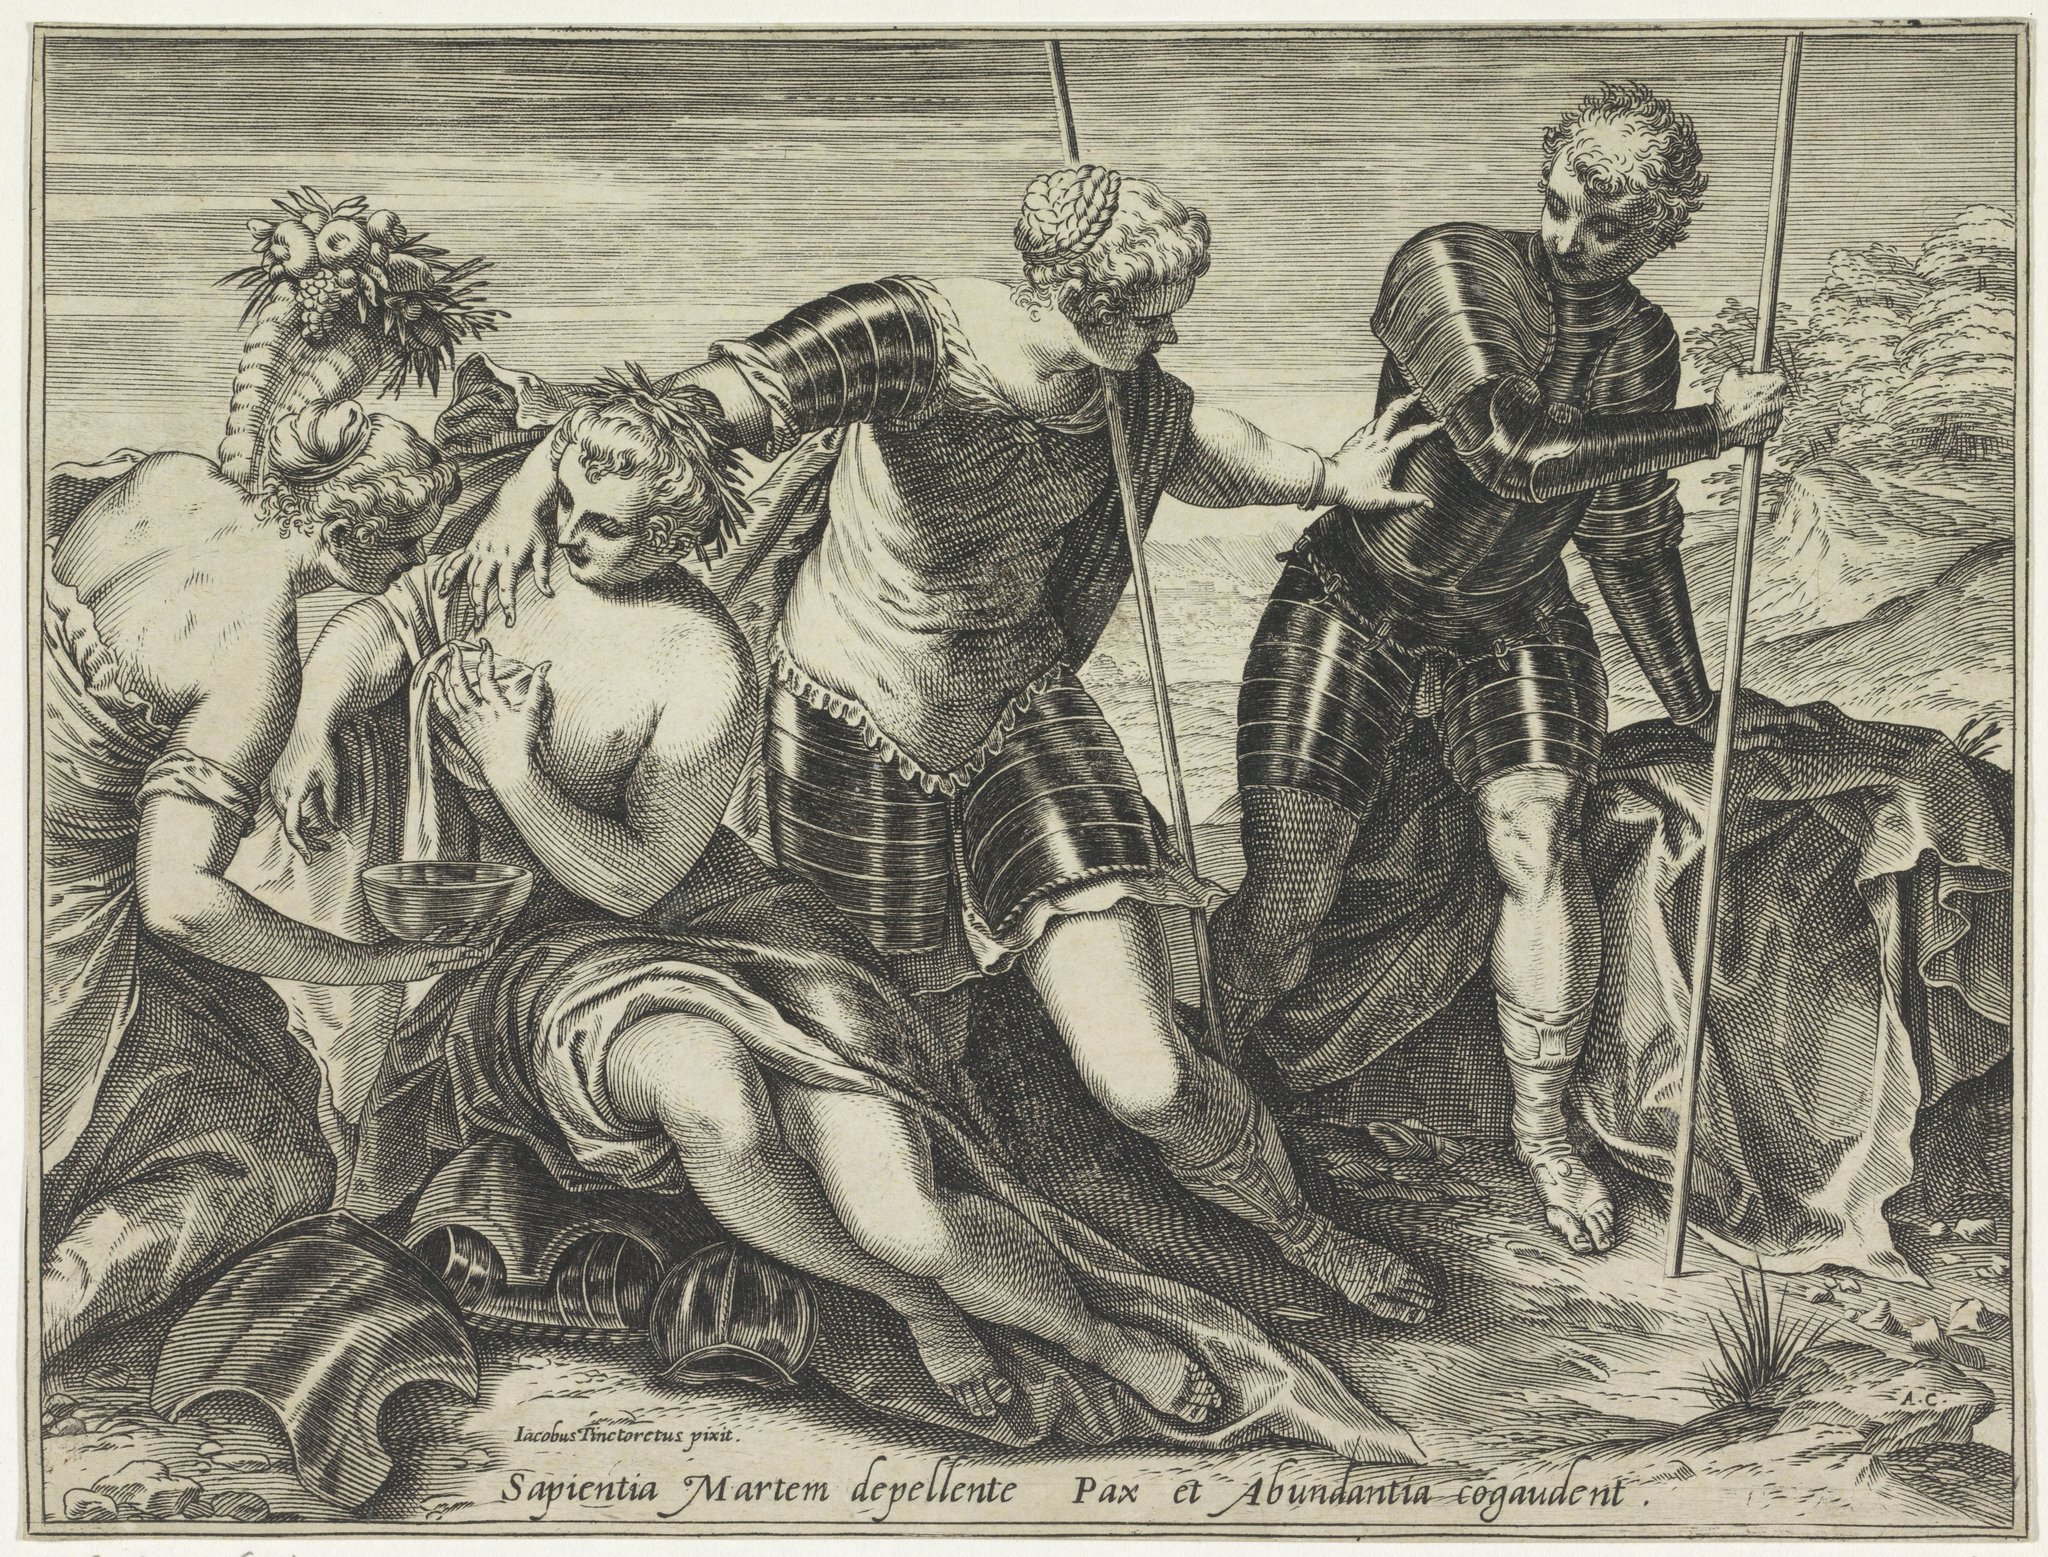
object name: print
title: Mars weggestuurd door Minerva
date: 1589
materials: paper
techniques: engraving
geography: italy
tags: (story of) mars (ares), (story of) minerva (pallas, athena), peace and prosperity, 'pax et abundantia'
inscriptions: collector's mark: Lugt 2228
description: Minerva stuurt Mars weg bij de personificaties van vrede en voorspoed.